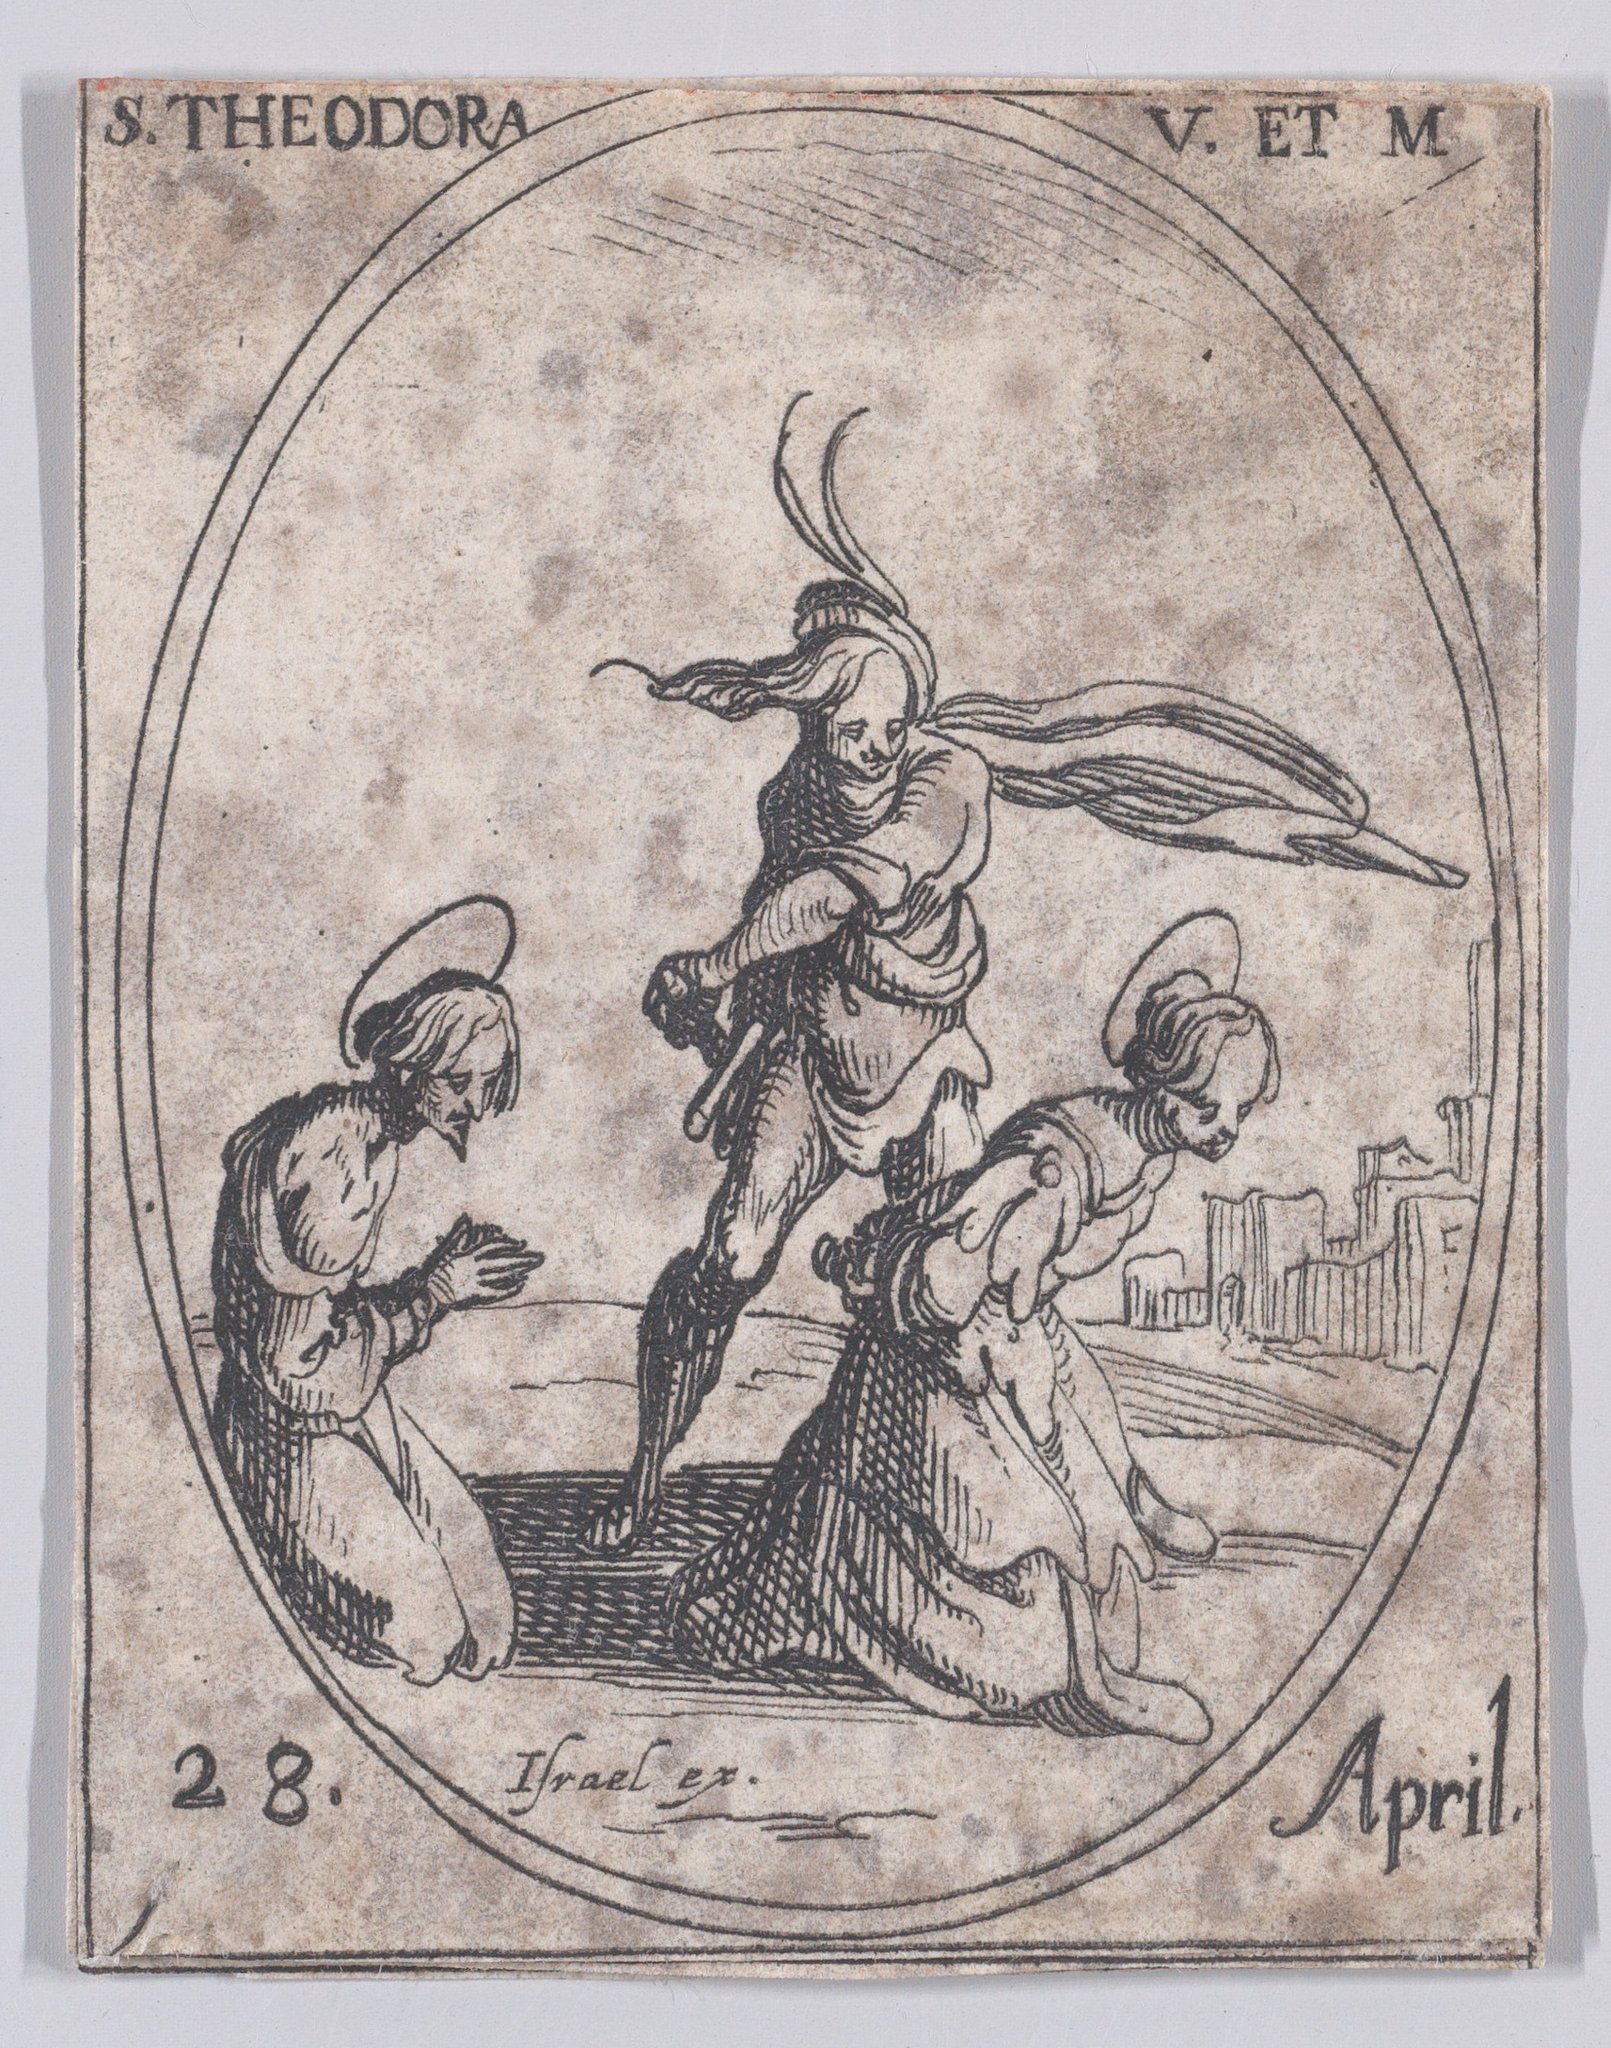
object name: print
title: Ste. Théodore, vierge et martyre (St. Theodora, Virgin and Martyr), April 28th, from "Les Images De Tous Les Saincts et Saintes de L'Année" (Images of All of the Saints and Religious Events of the Year)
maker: jacques callot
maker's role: artist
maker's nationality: french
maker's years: 1592-1635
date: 1636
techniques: etching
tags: men,women,saints